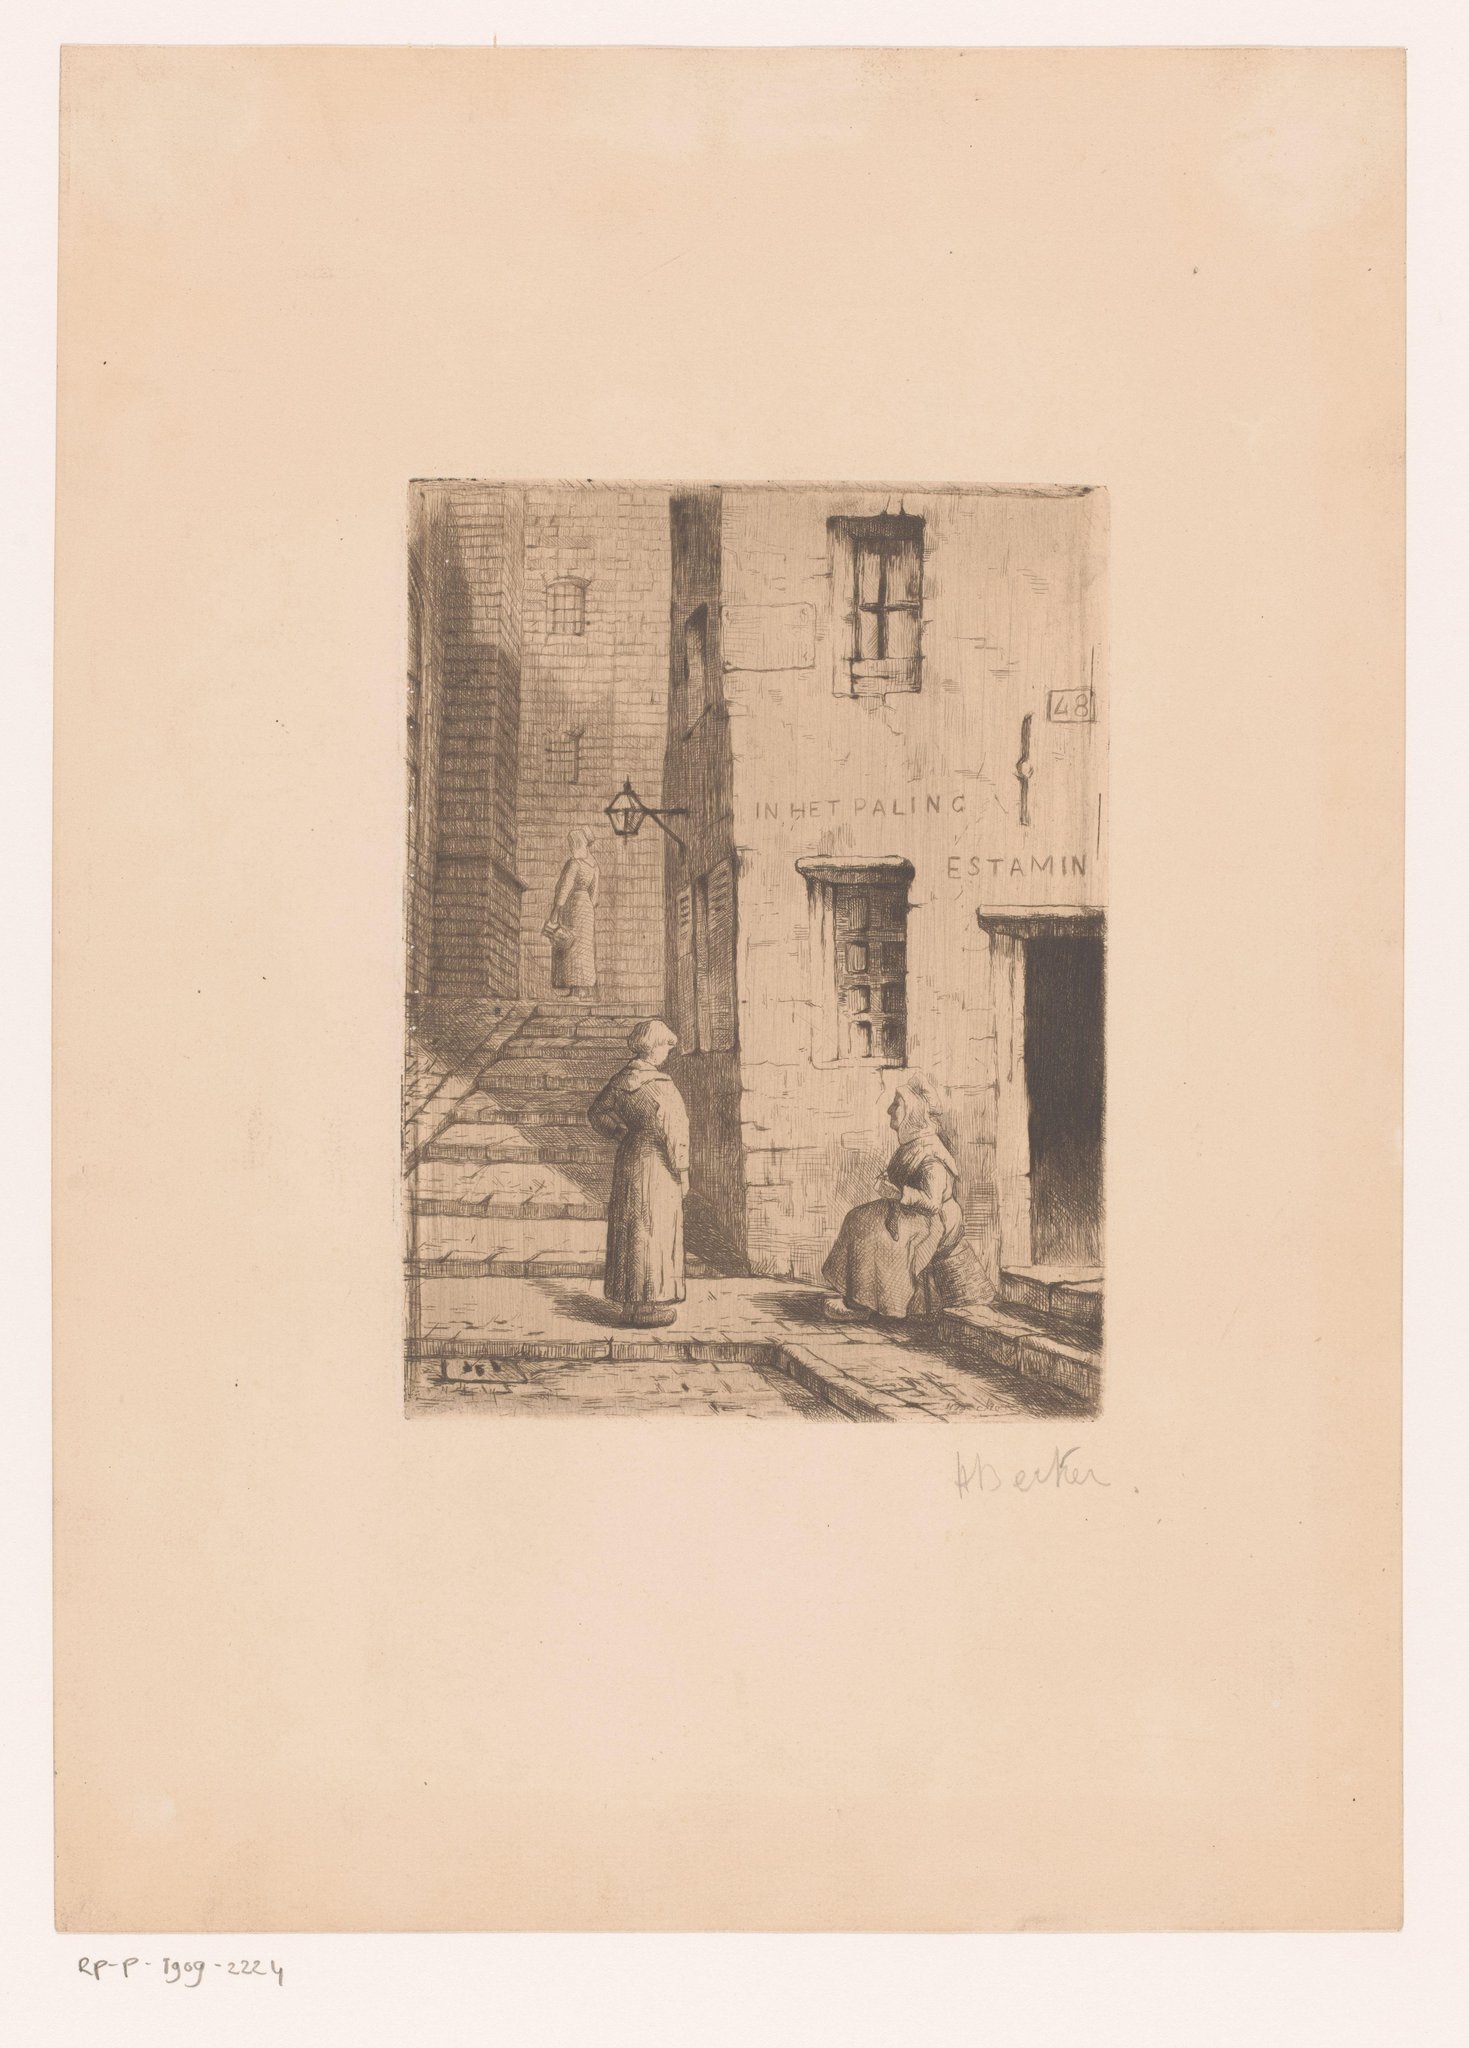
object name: print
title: Gezicht op een straat met figuren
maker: h. becker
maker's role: print maker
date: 1850-1899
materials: paper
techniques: etching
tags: street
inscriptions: collector's mark: Lugt 2228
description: Mogelijk gaat het om een straat in Antwerpen.